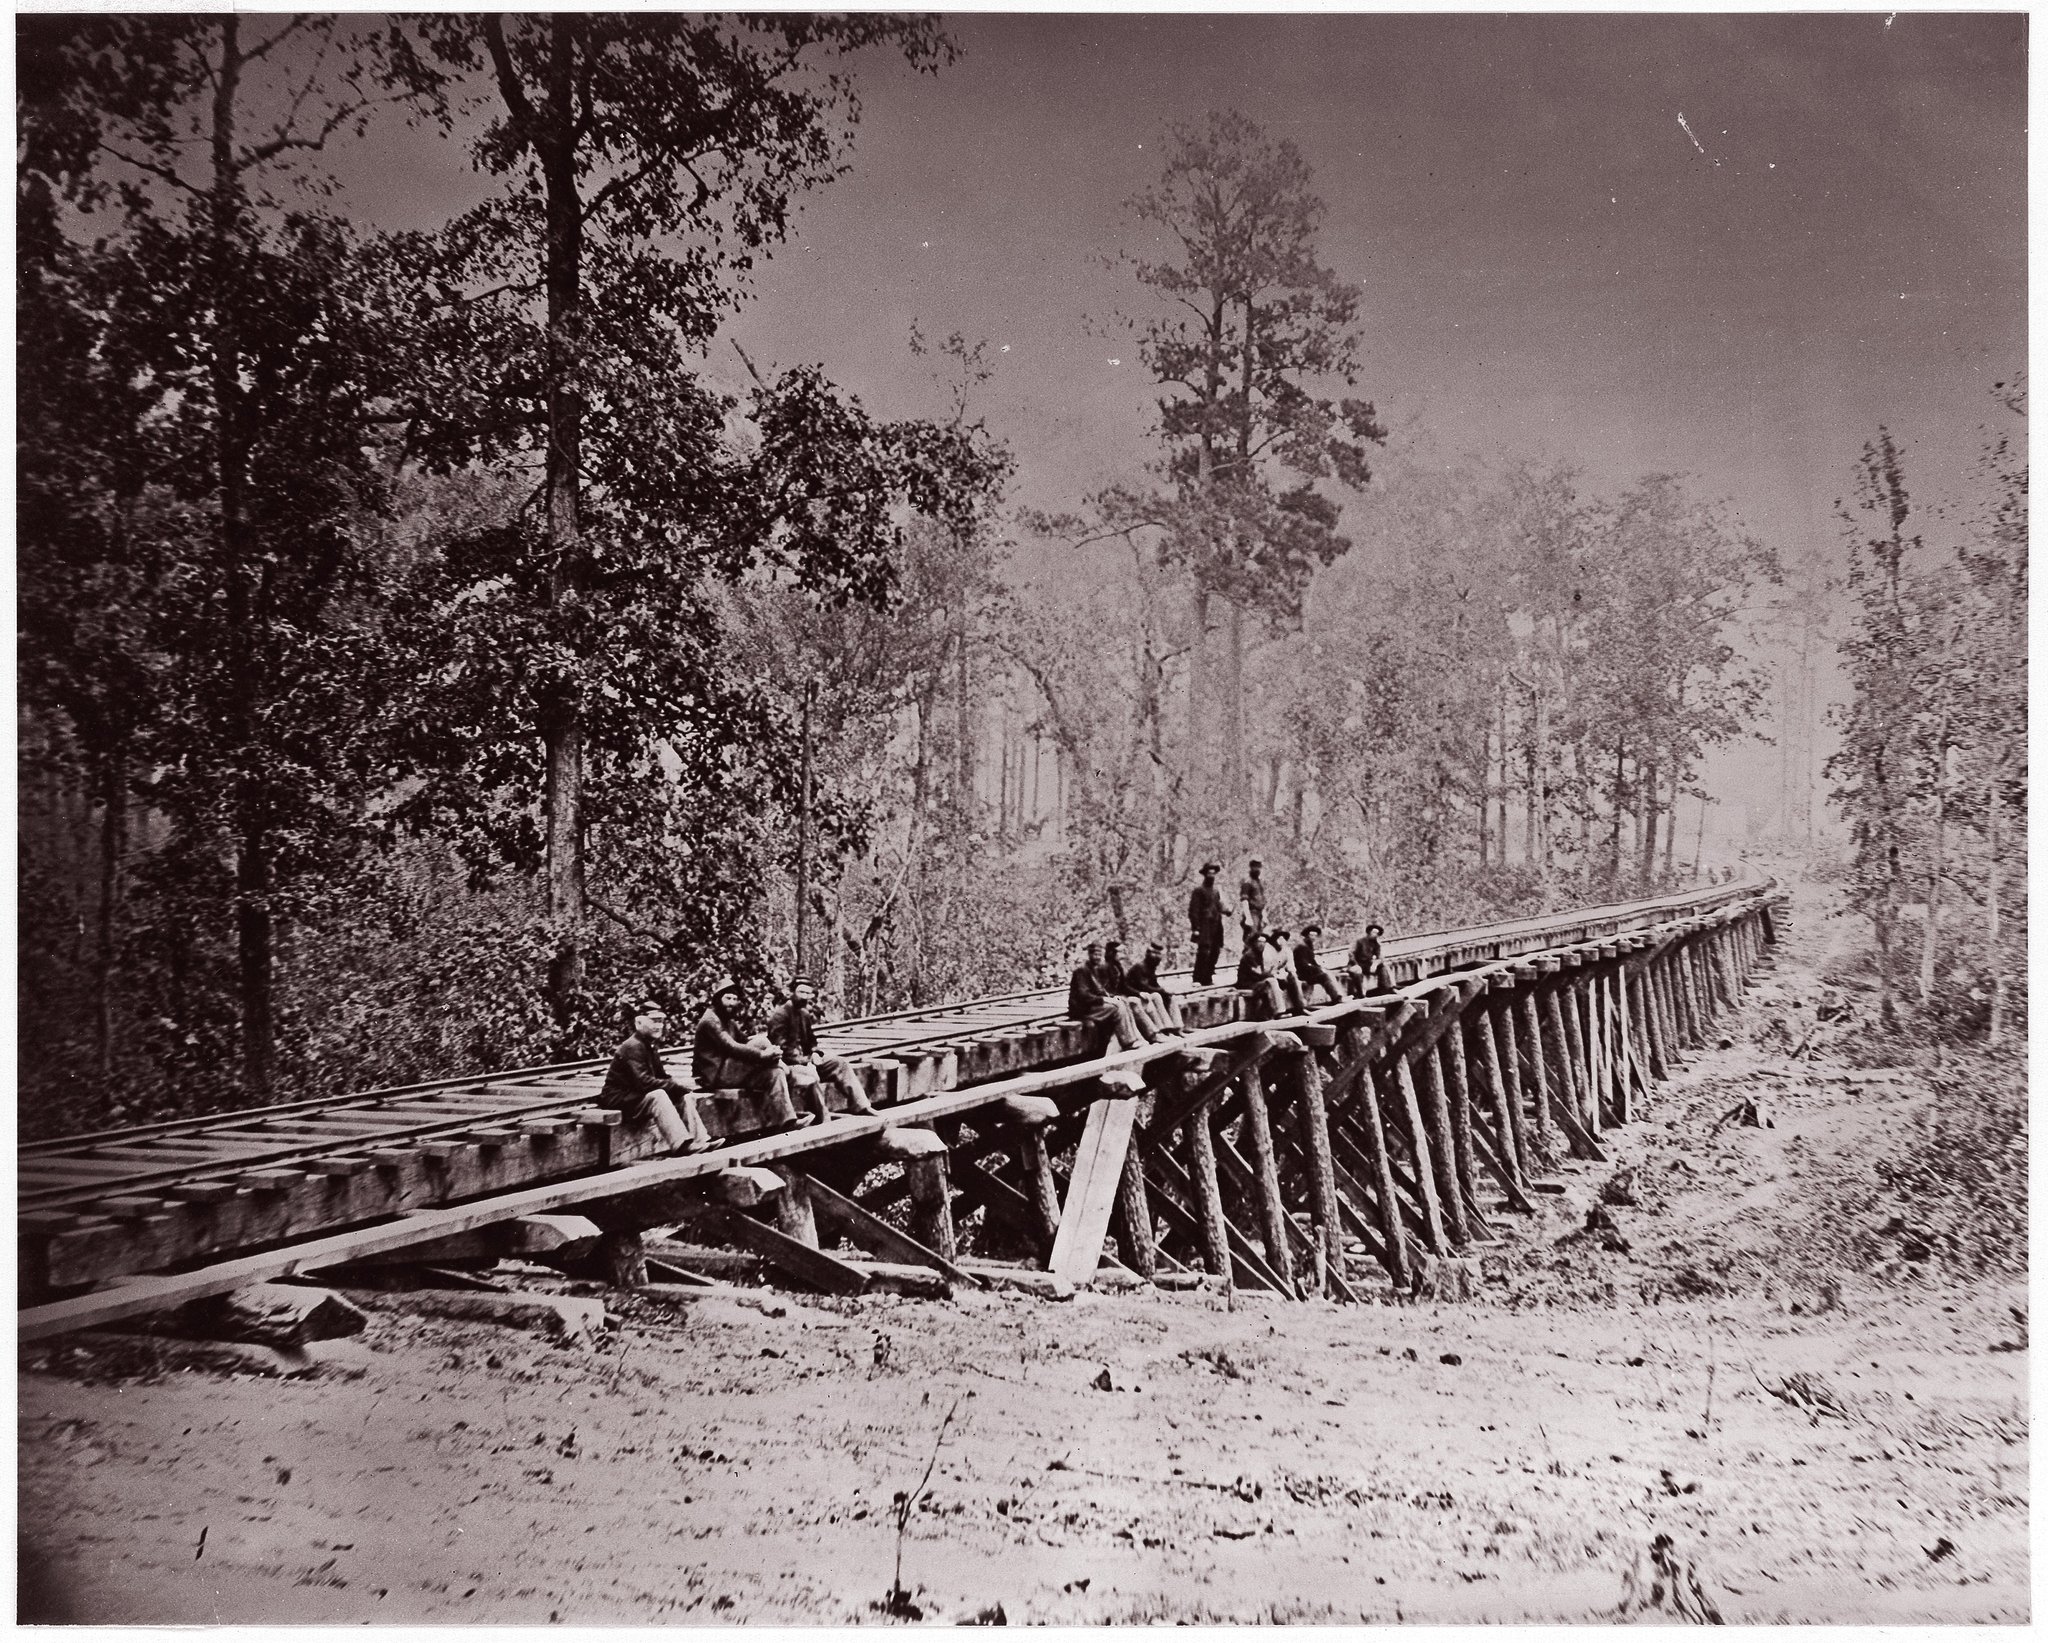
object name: photograph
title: [Bridge No.2, U.S. Military Railroad to City Point, Virginia]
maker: andrew joseph russell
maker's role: artist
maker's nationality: american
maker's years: 1830-1902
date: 1861-1865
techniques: albumen silver print, glass negative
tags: bridges,railways,american civil war,men